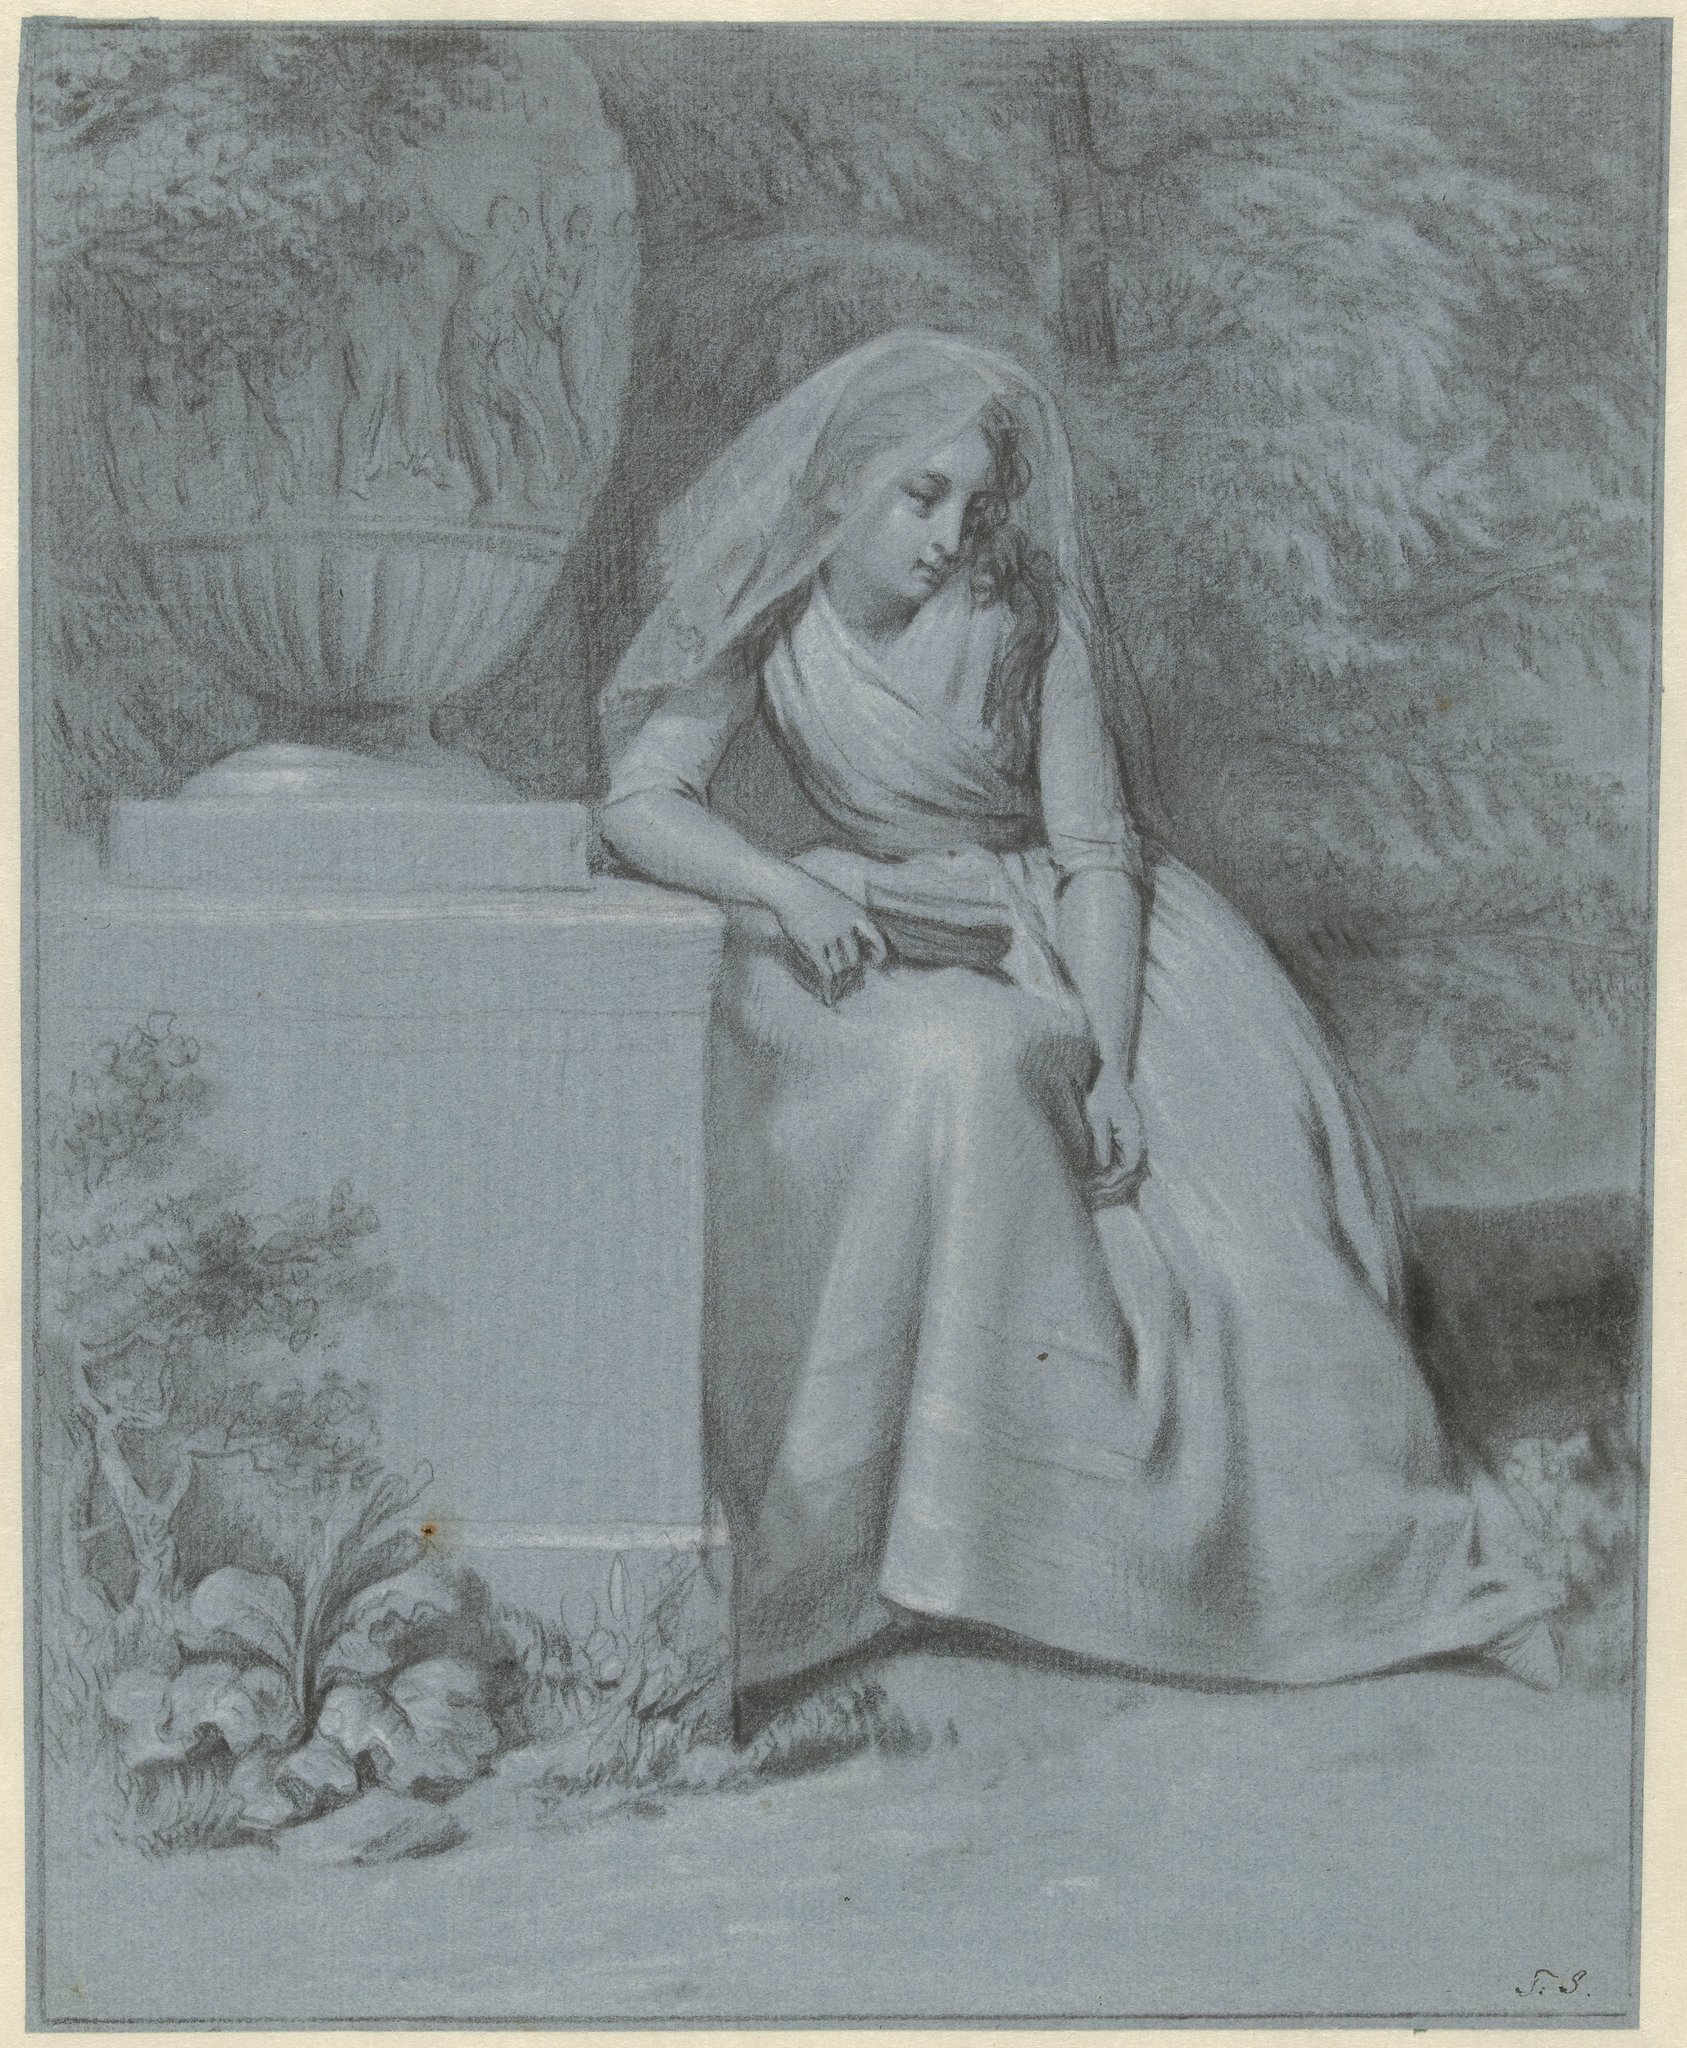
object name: drawing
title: Vrouw zittend in een tuin naast een grote tuinvaas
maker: taco scheltema (i)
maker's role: draughtsman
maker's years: 1760-1837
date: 1770-1837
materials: chalk, paper